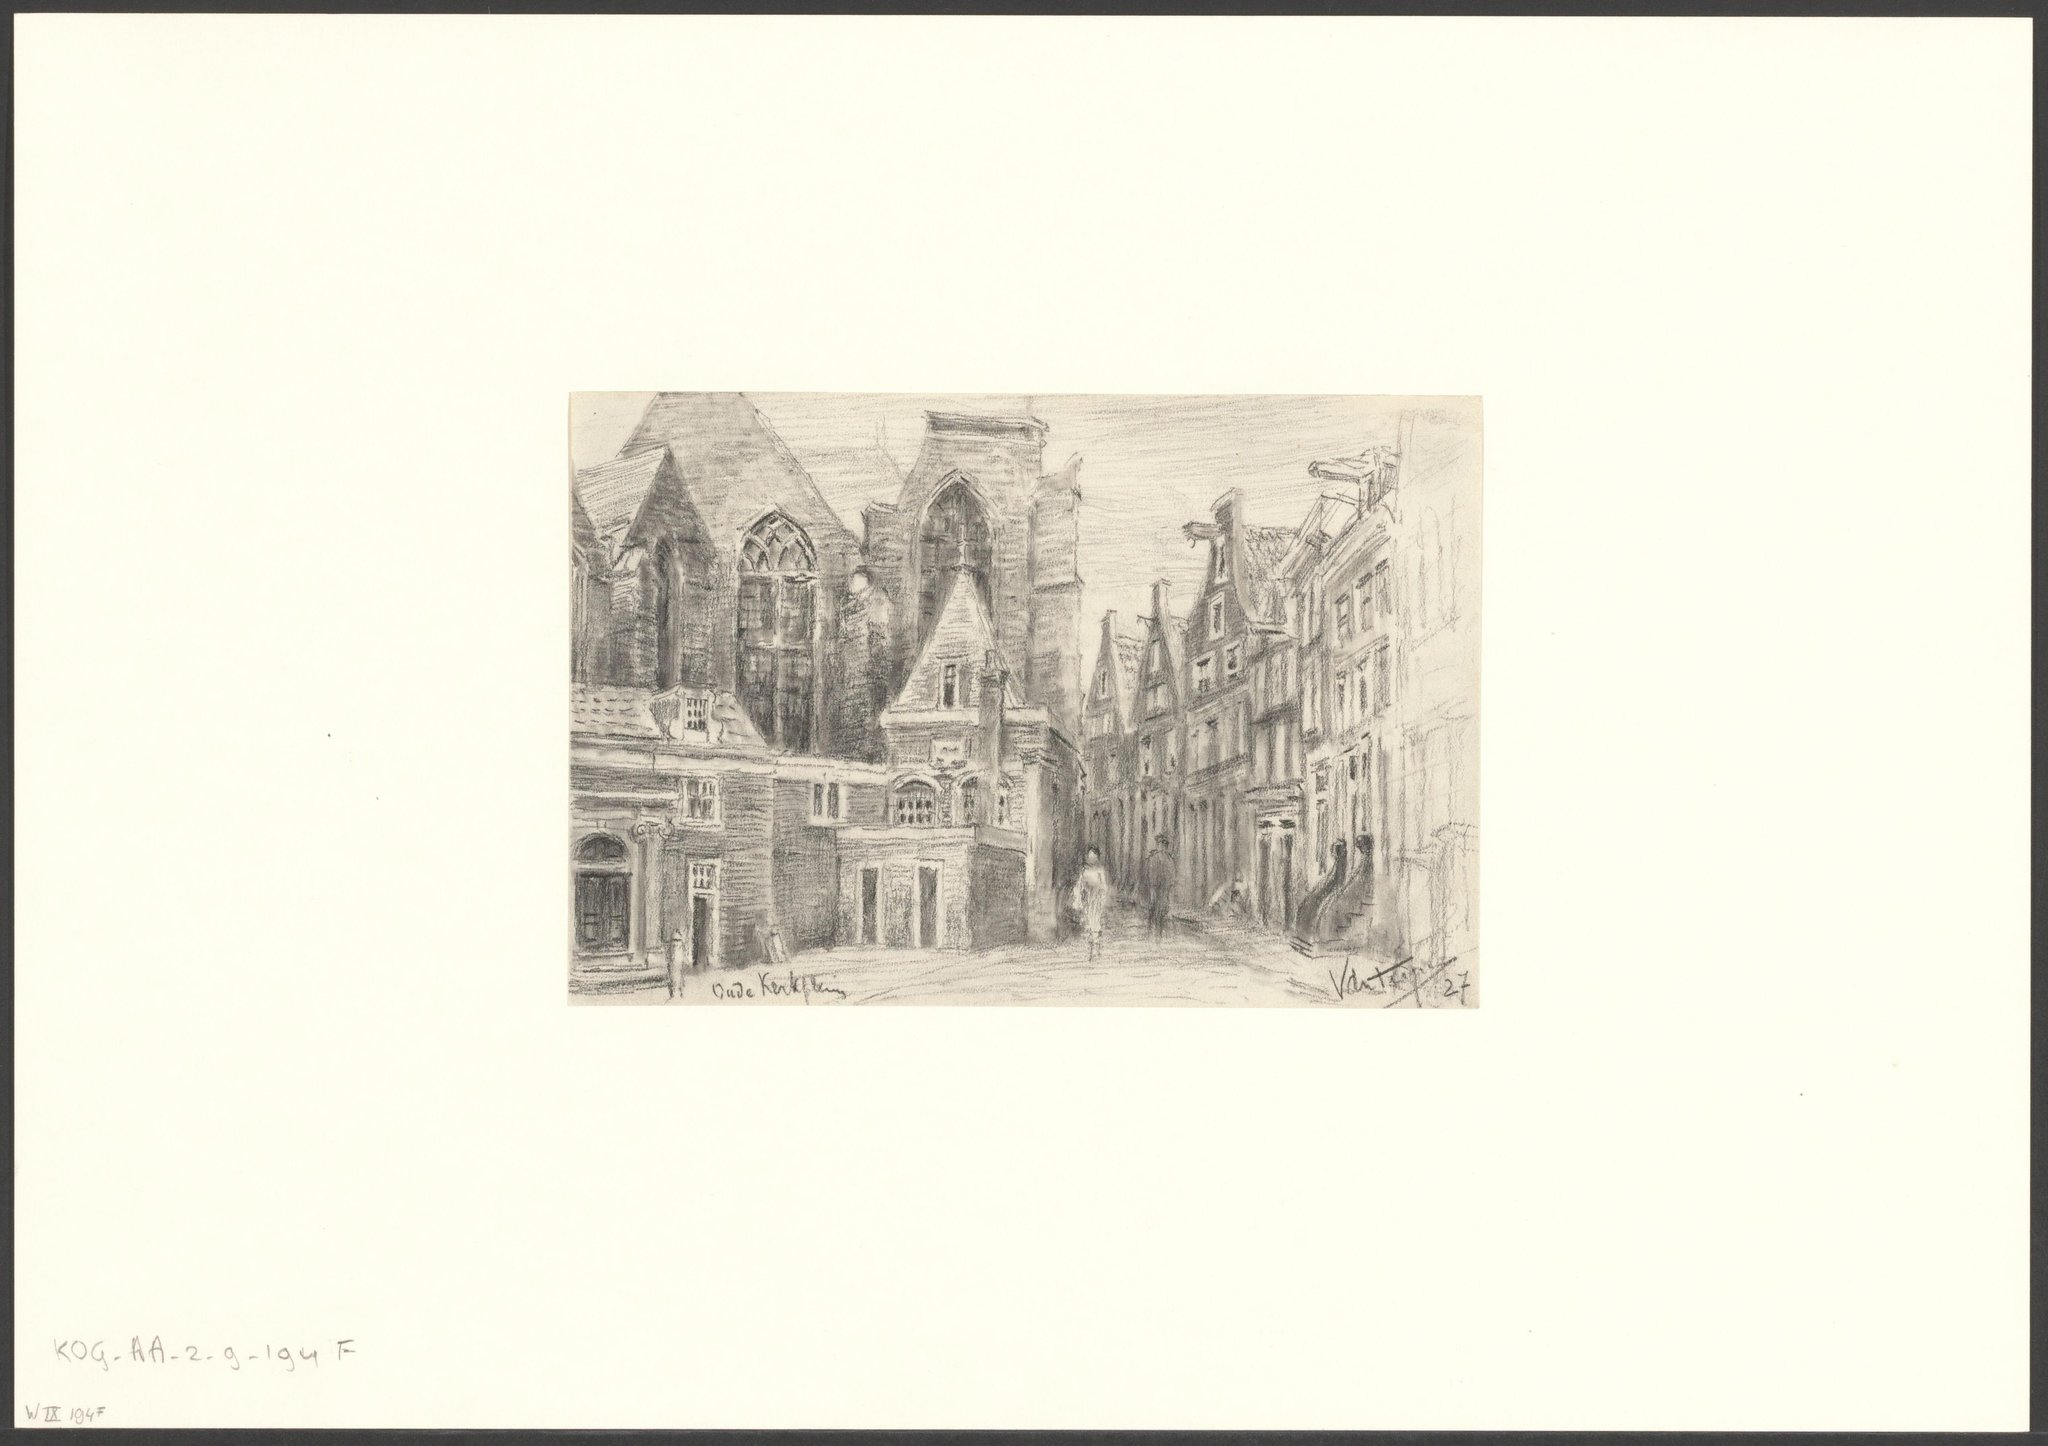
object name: drawing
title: Gezicht op de Oude Kerk en het Oudekerksplein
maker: anthonie van teijn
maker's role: draughtsman, painter, print maker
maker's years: 1863-1943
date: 1906-1927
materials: chalk, paper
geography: amsterdam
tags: square, place, circus, etc., church (exterior)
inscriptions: inscription: ‘Oude Kerk kerksplein met oude / noord zijde geteekend. Juni 1927. / [...]’, signature and date: ‘Van Teyne 27’, inscription: ‘Oude Kerkplein’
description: Tekening binnen de Atlas Van Eck ingedeeld op wijknummer 9.